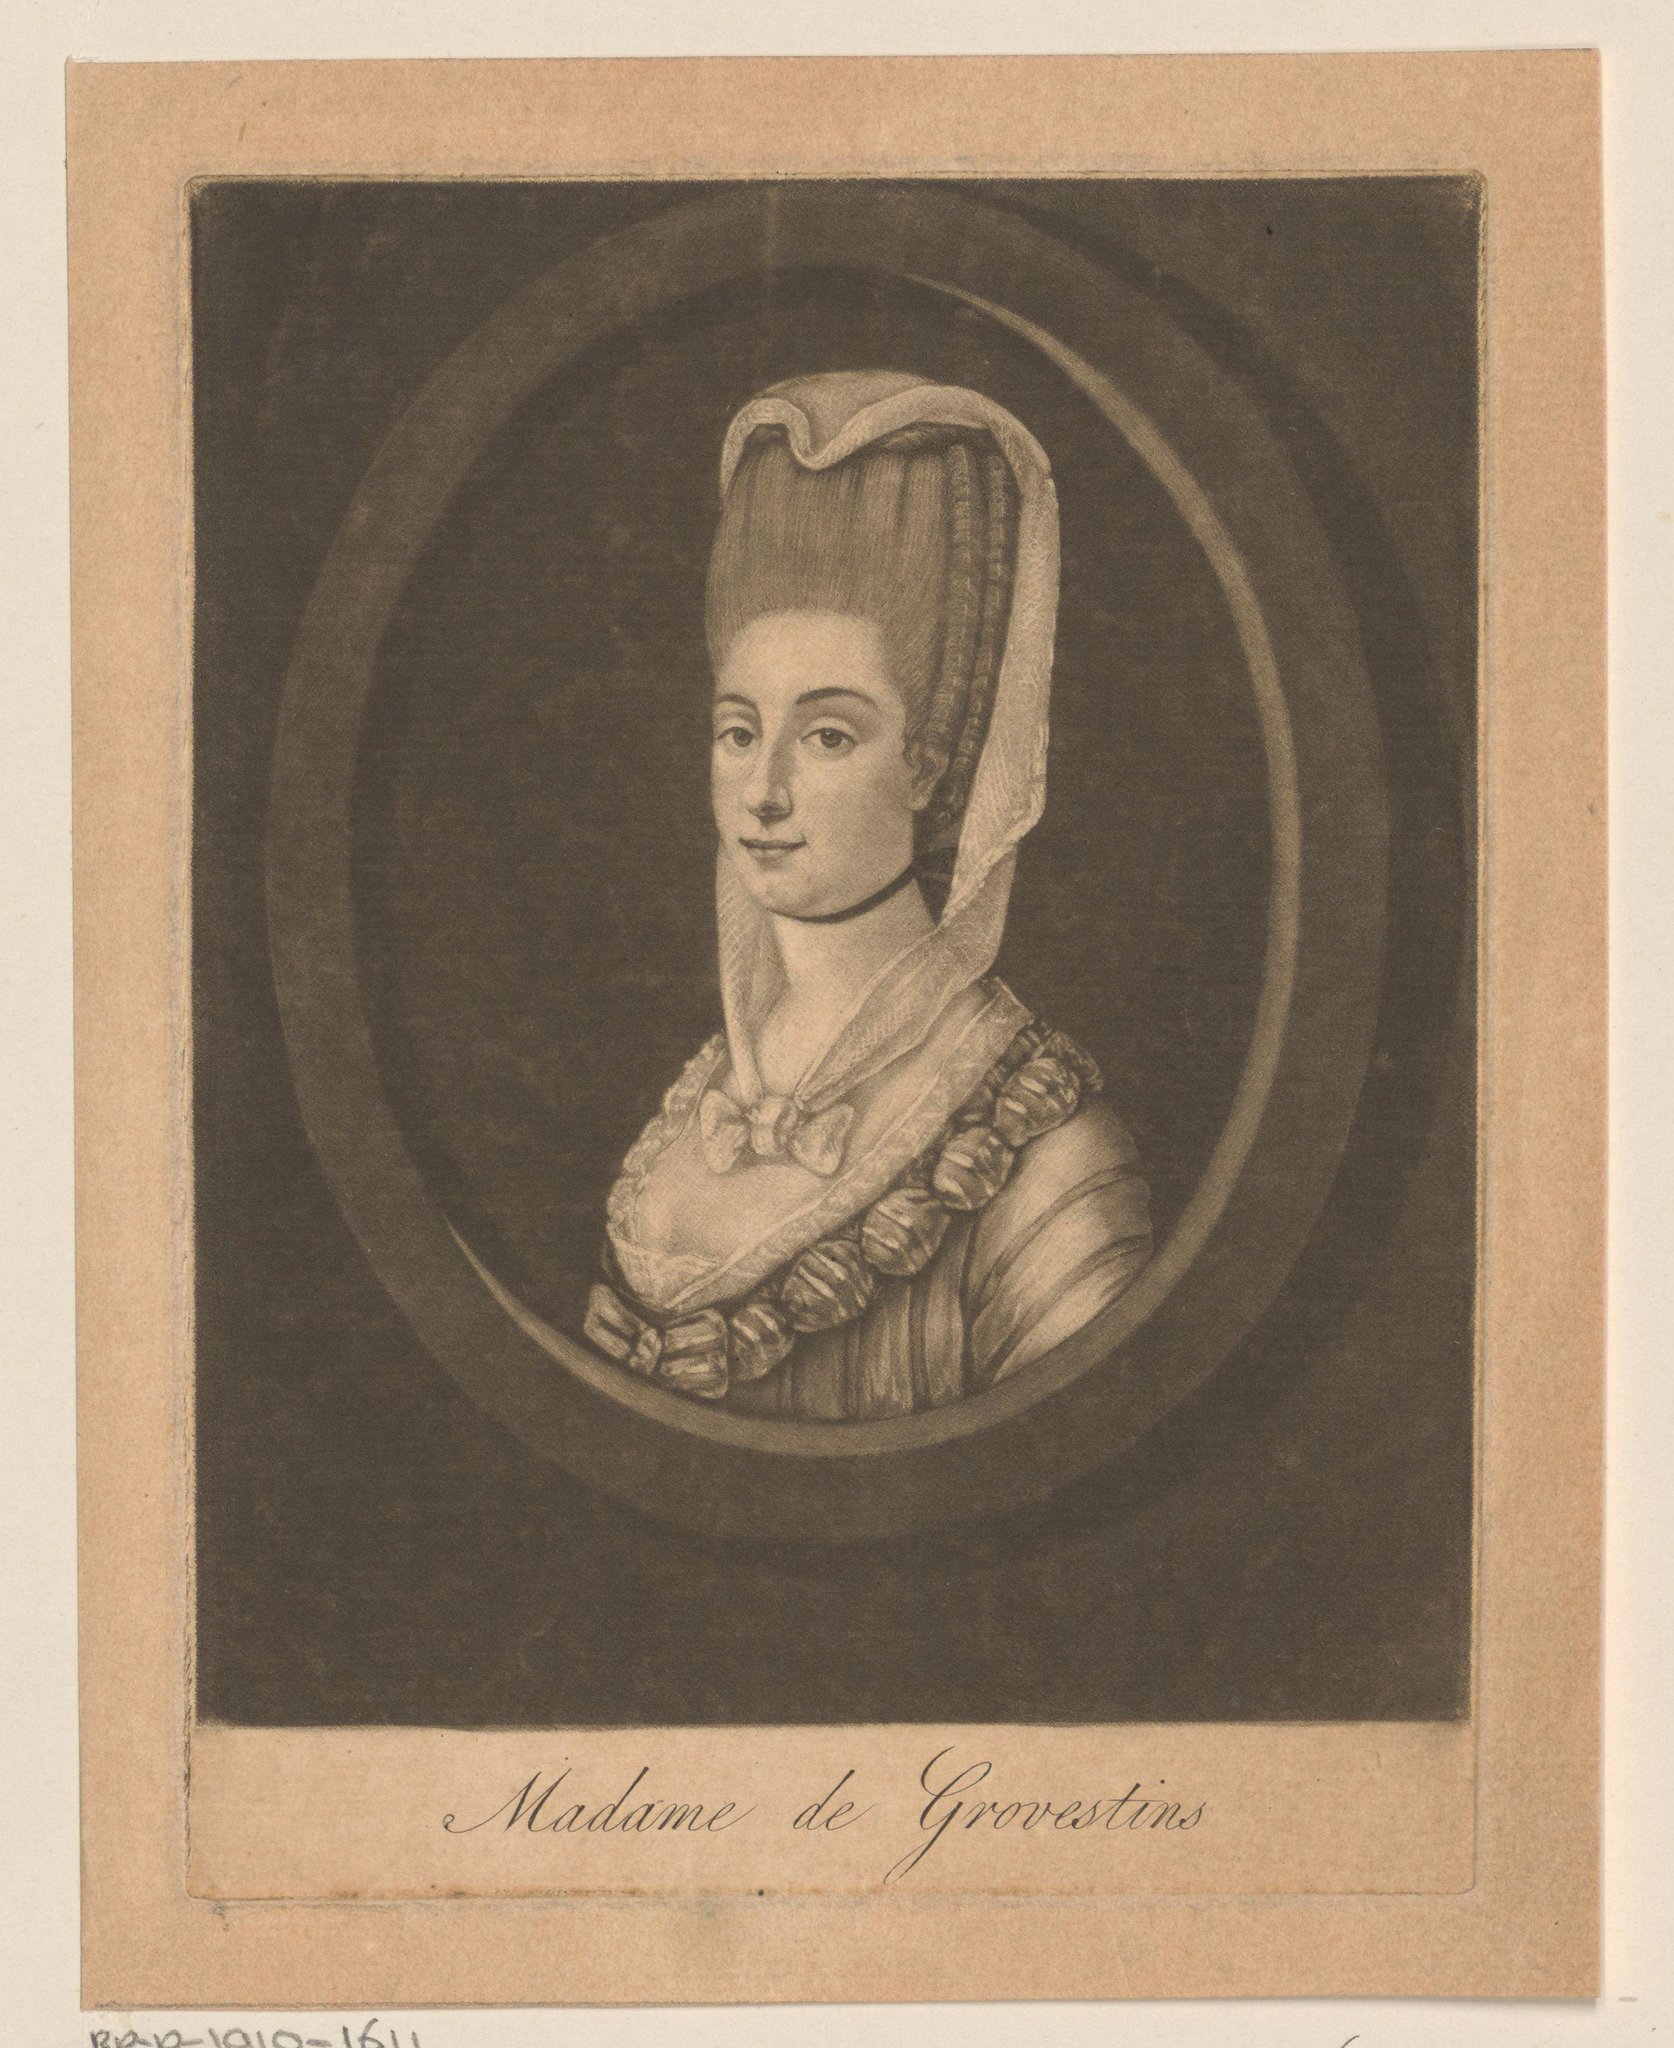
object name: print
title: Madame de Grovestins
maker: Anonymous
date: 1750-1899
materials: paper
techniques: mezzotint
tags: historical persons not known by name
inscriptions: collector's mark: Lugt 2228